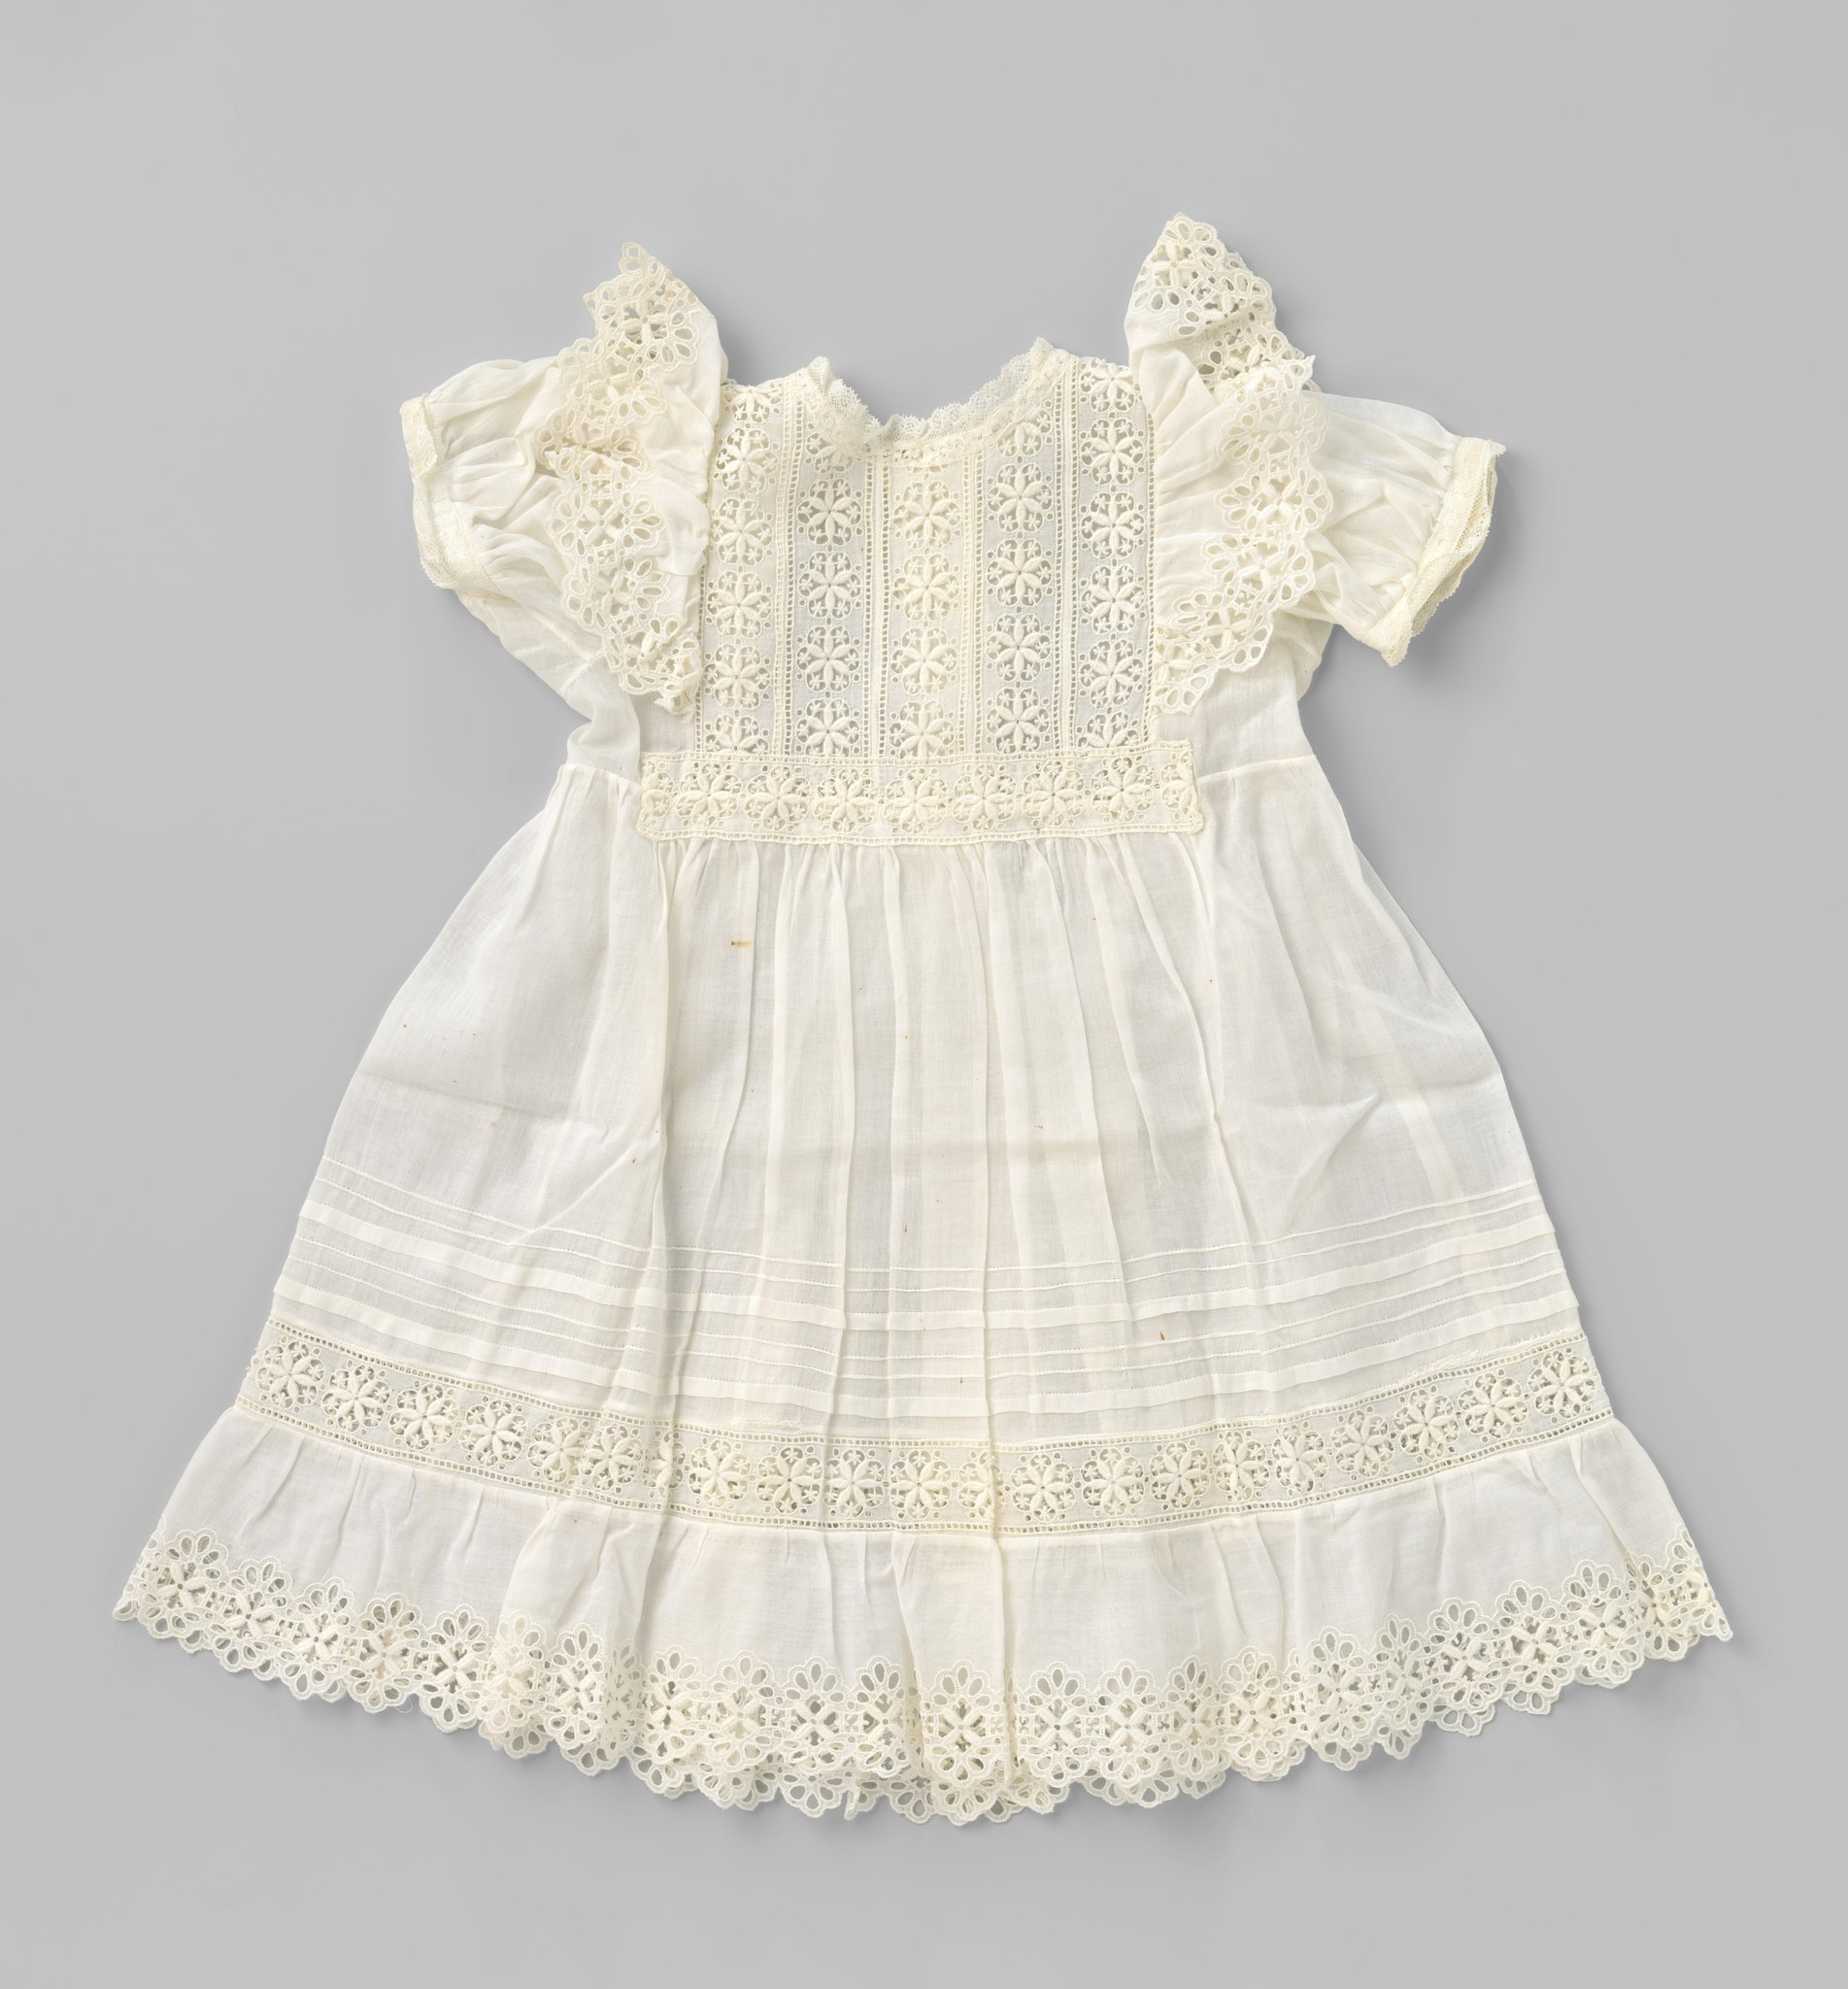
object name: childrenswear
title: Witte kinderjapon met korte mouwen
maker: Anonymous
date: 1900-1950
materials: textile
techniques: embroidered, lace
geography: europe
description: Aan de voorzijde sluit de japon met vier rond parelmoerkleurige knopen. De mouwen en de hals zijn afgezet met stroken Valenciennes kant. De onderzijde is geschulpt en voorzien van witwerk.